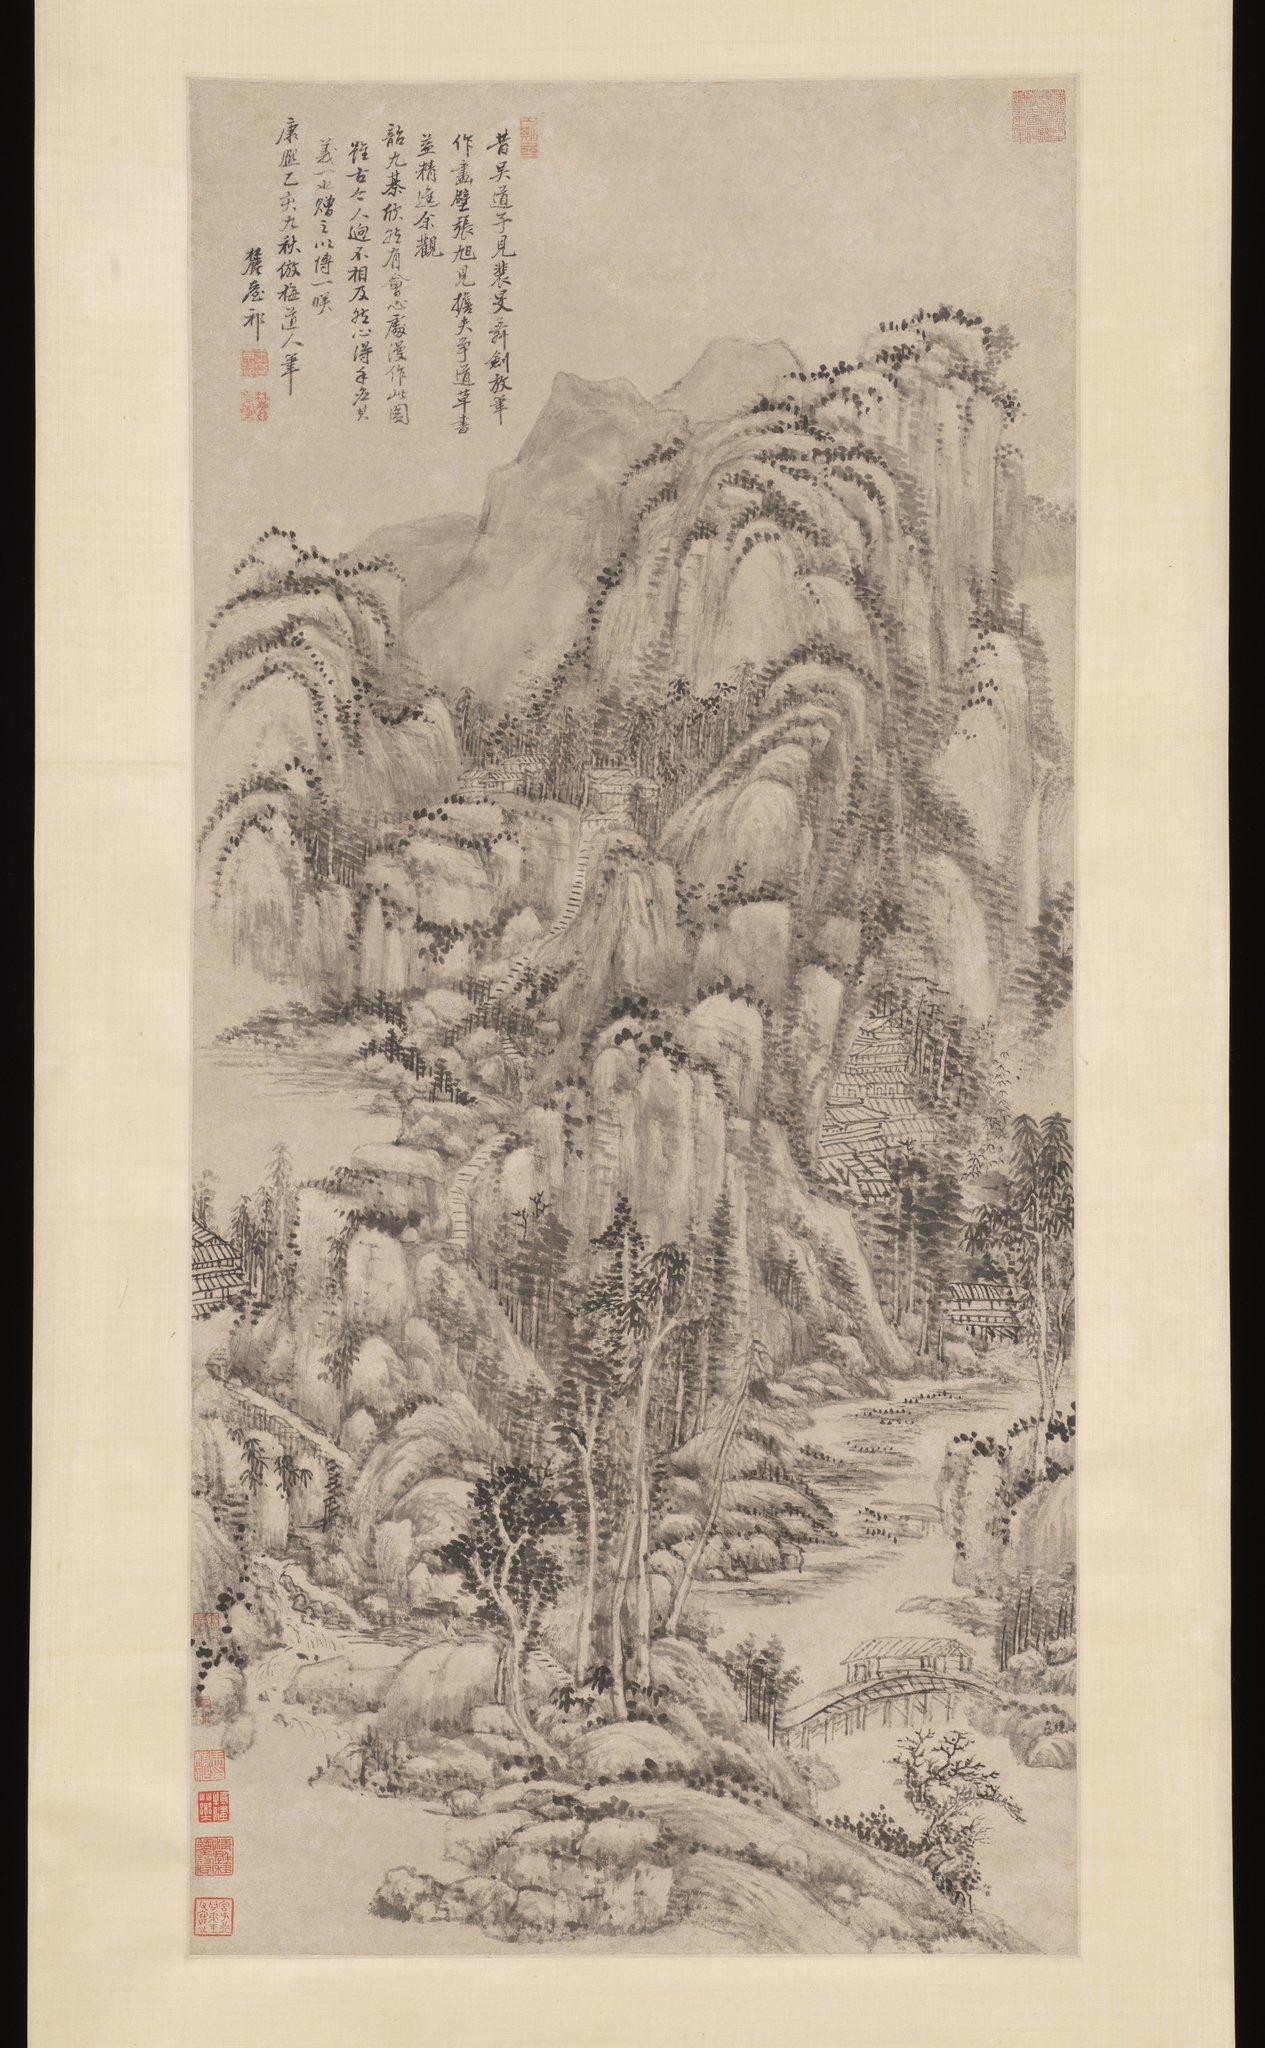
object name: hanging scroll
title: Landscape after Wu Zhen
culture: chinese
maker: wang yuanqi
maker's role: artist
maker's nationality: chinese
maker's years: 1642-1715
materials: ink, paper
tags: mountains,landscapes